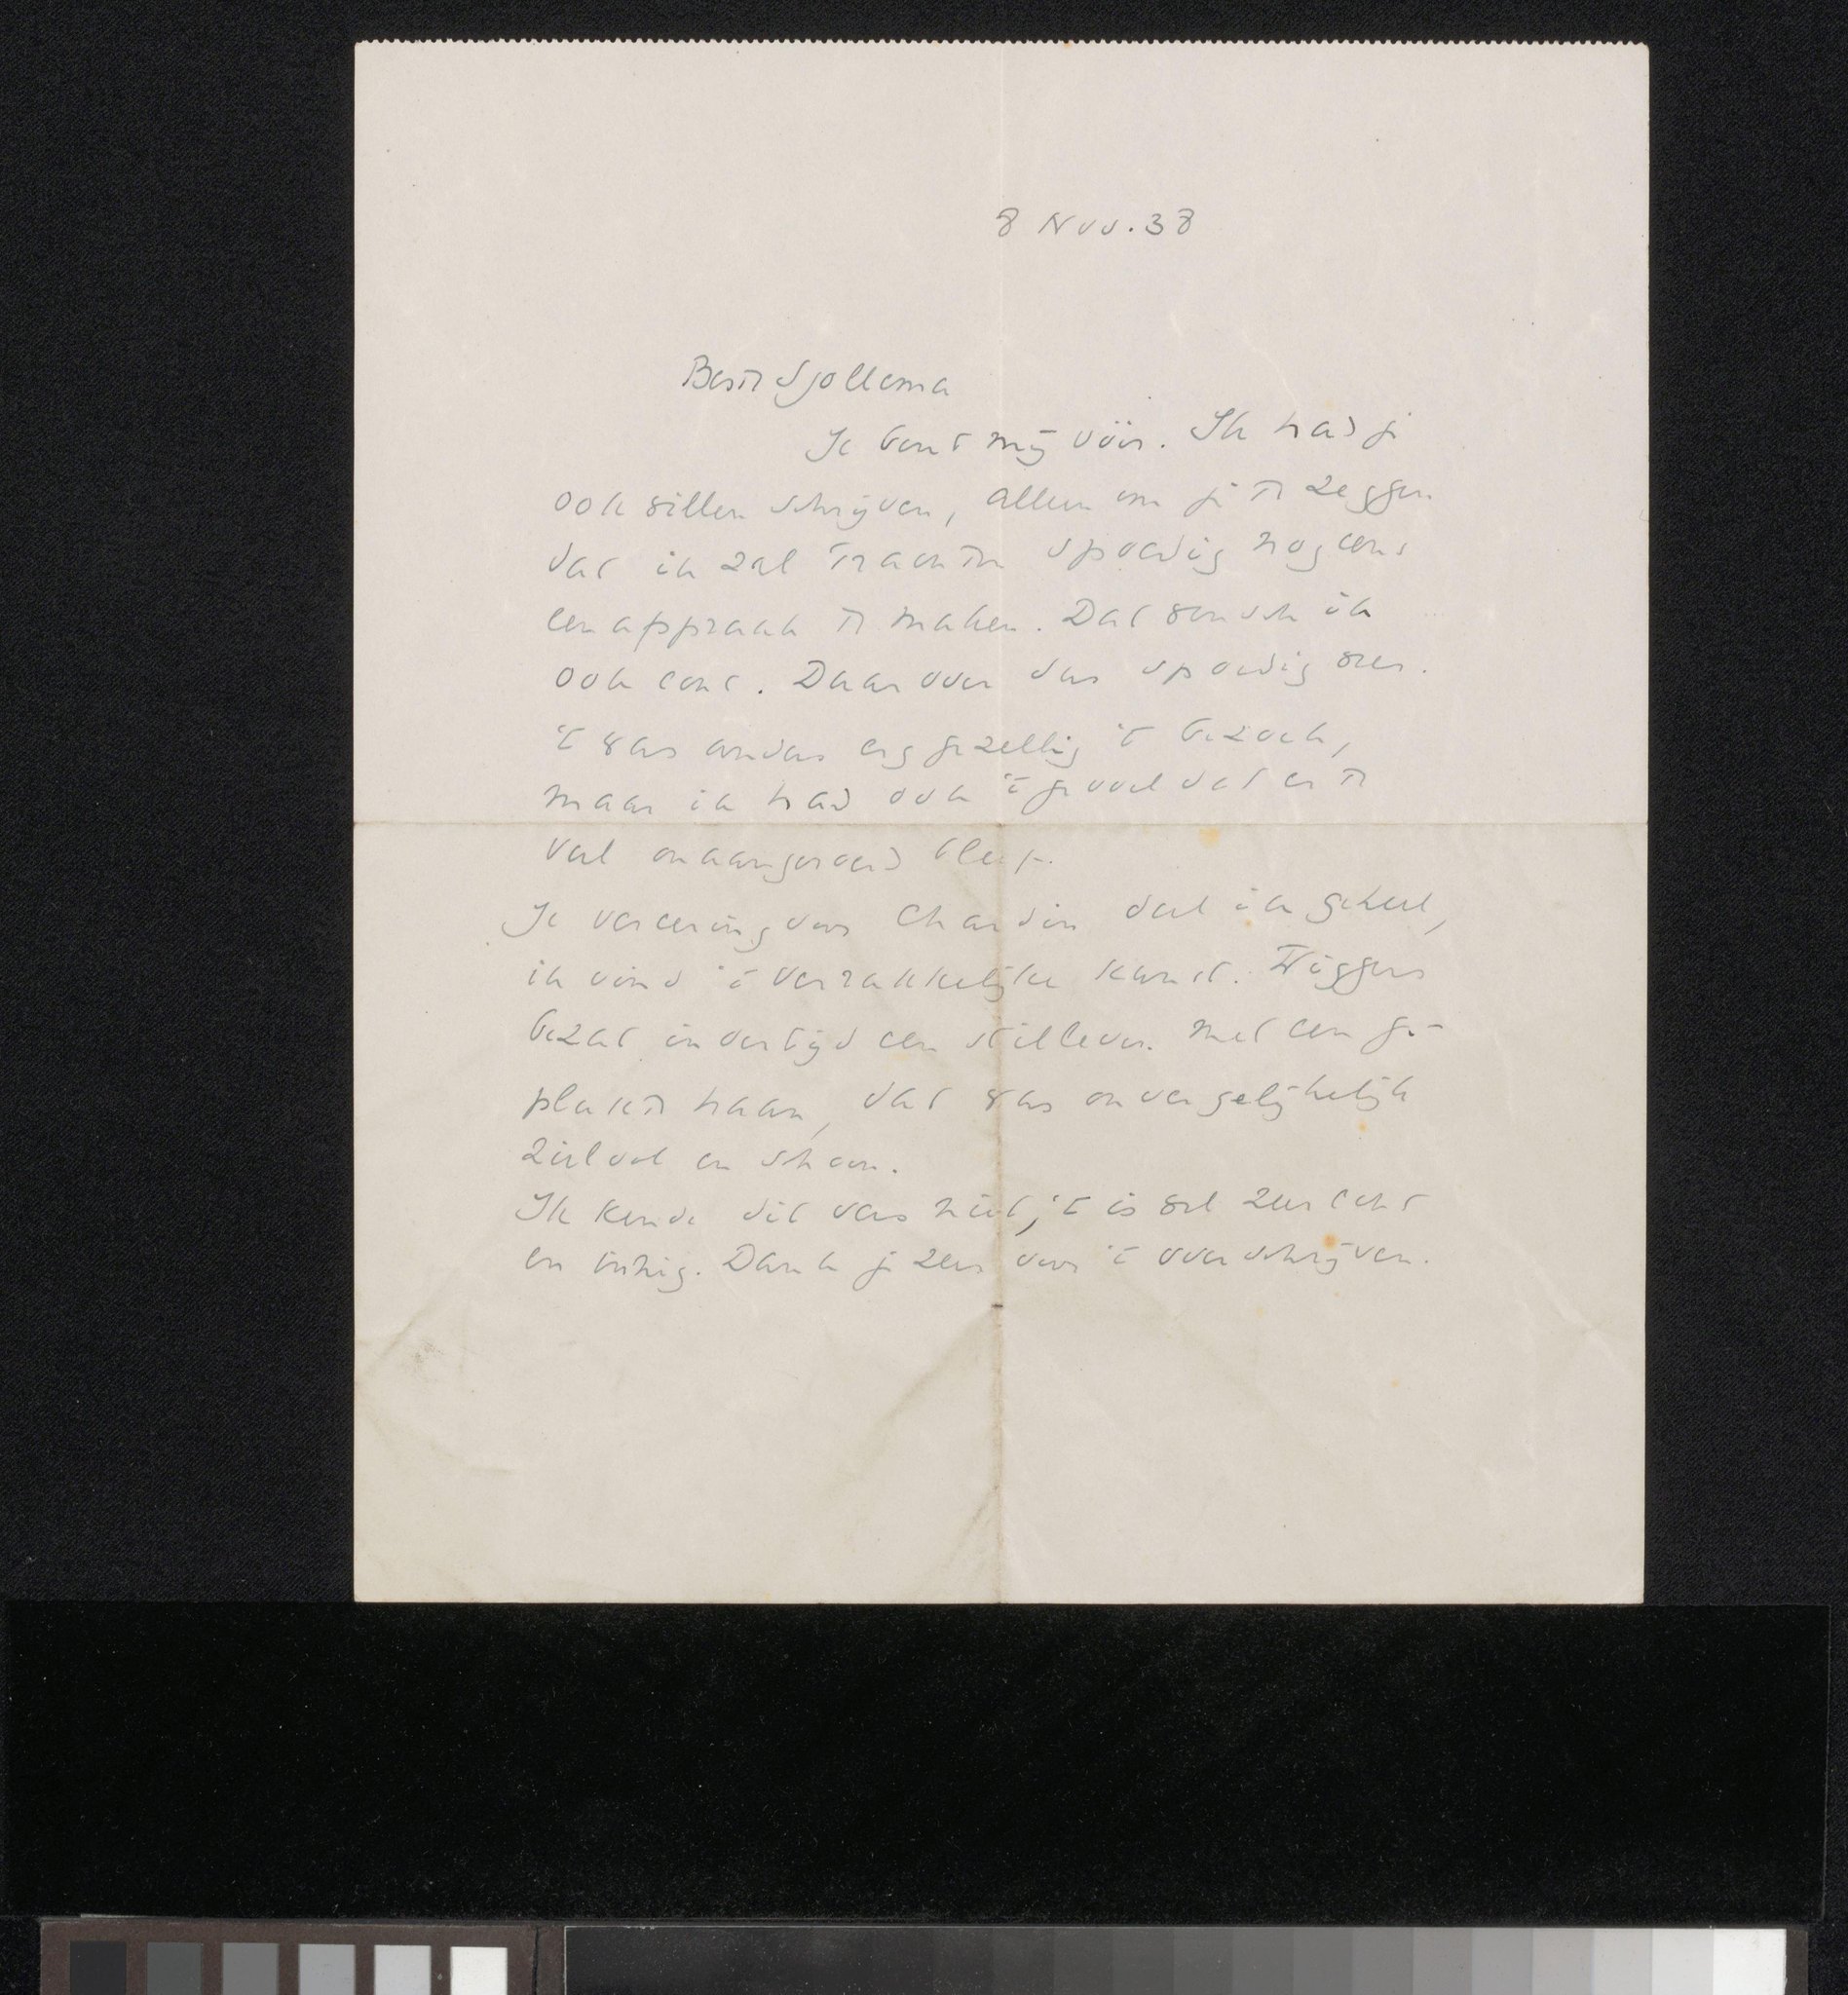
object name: letter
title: Brief aan Joop Sjollema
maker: richard nicolaüs roland holst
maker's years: 1868-1938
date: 1938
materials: ink, paper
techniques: pen, writing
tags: delft, johannes vermeer, amsterdam, print maker, joop sjollema, paris, draughtsman, jean baptiste siméon chardin, the hague, painter, derk wiggers, painting (including book-illumination, miniature-painting)